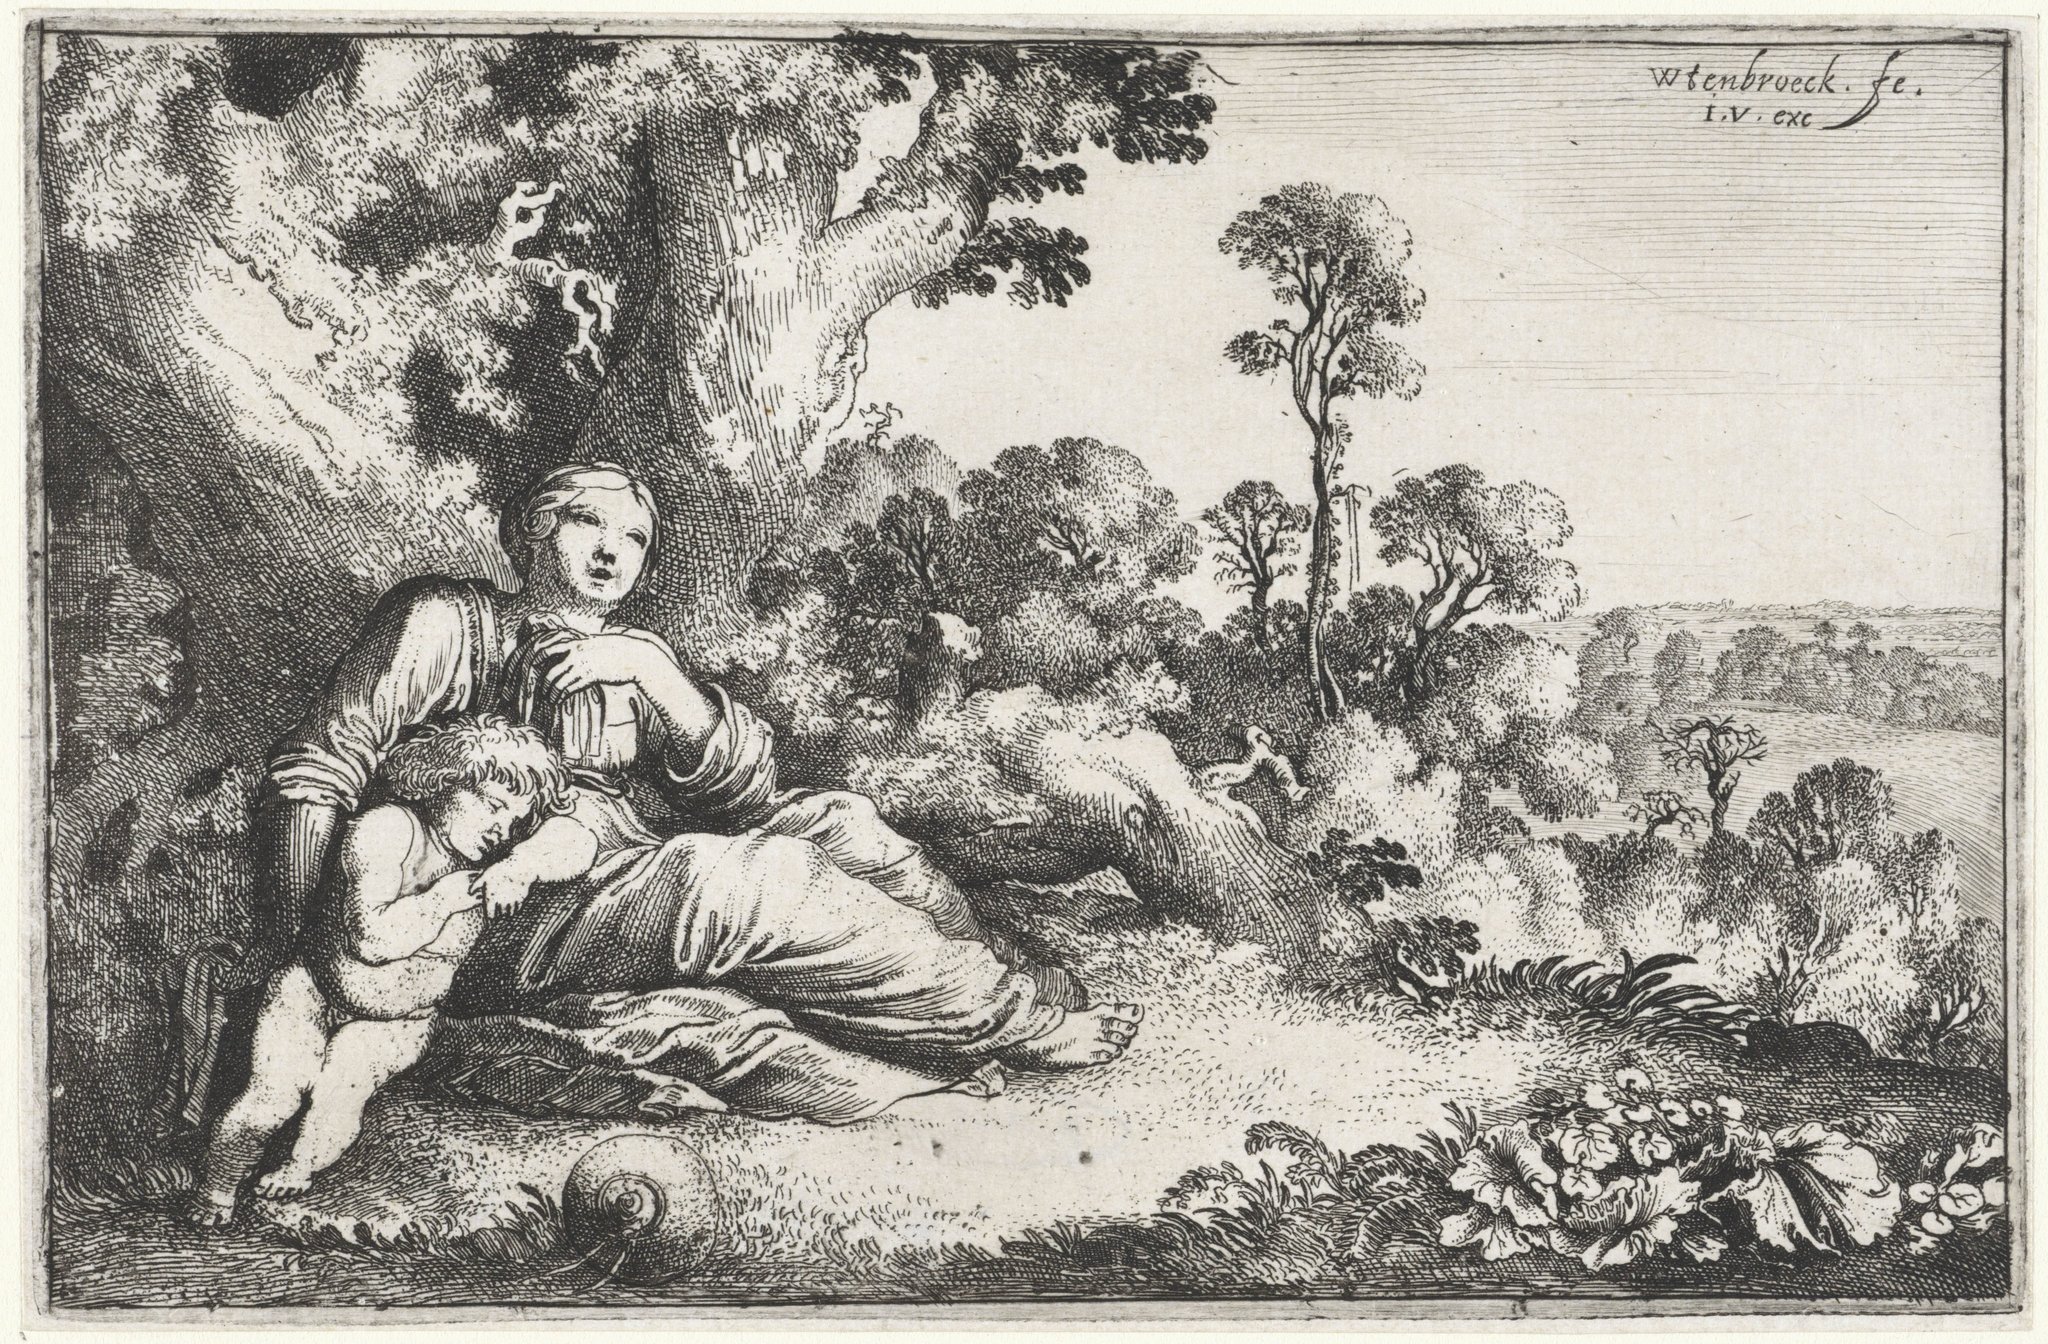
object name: print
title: Hagar en Ismaël in de woestijn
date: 1618-1628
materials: paper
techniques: engraving, etching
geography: enkhuizen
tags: hagar and ishmael in the wilderness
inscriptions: collector's mark, collector's mark: Lugt 2760, collector's mark: Lugt 2228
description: Hagar rust aan de voet van een dikke boom. Ismaël leunt tegen haar.